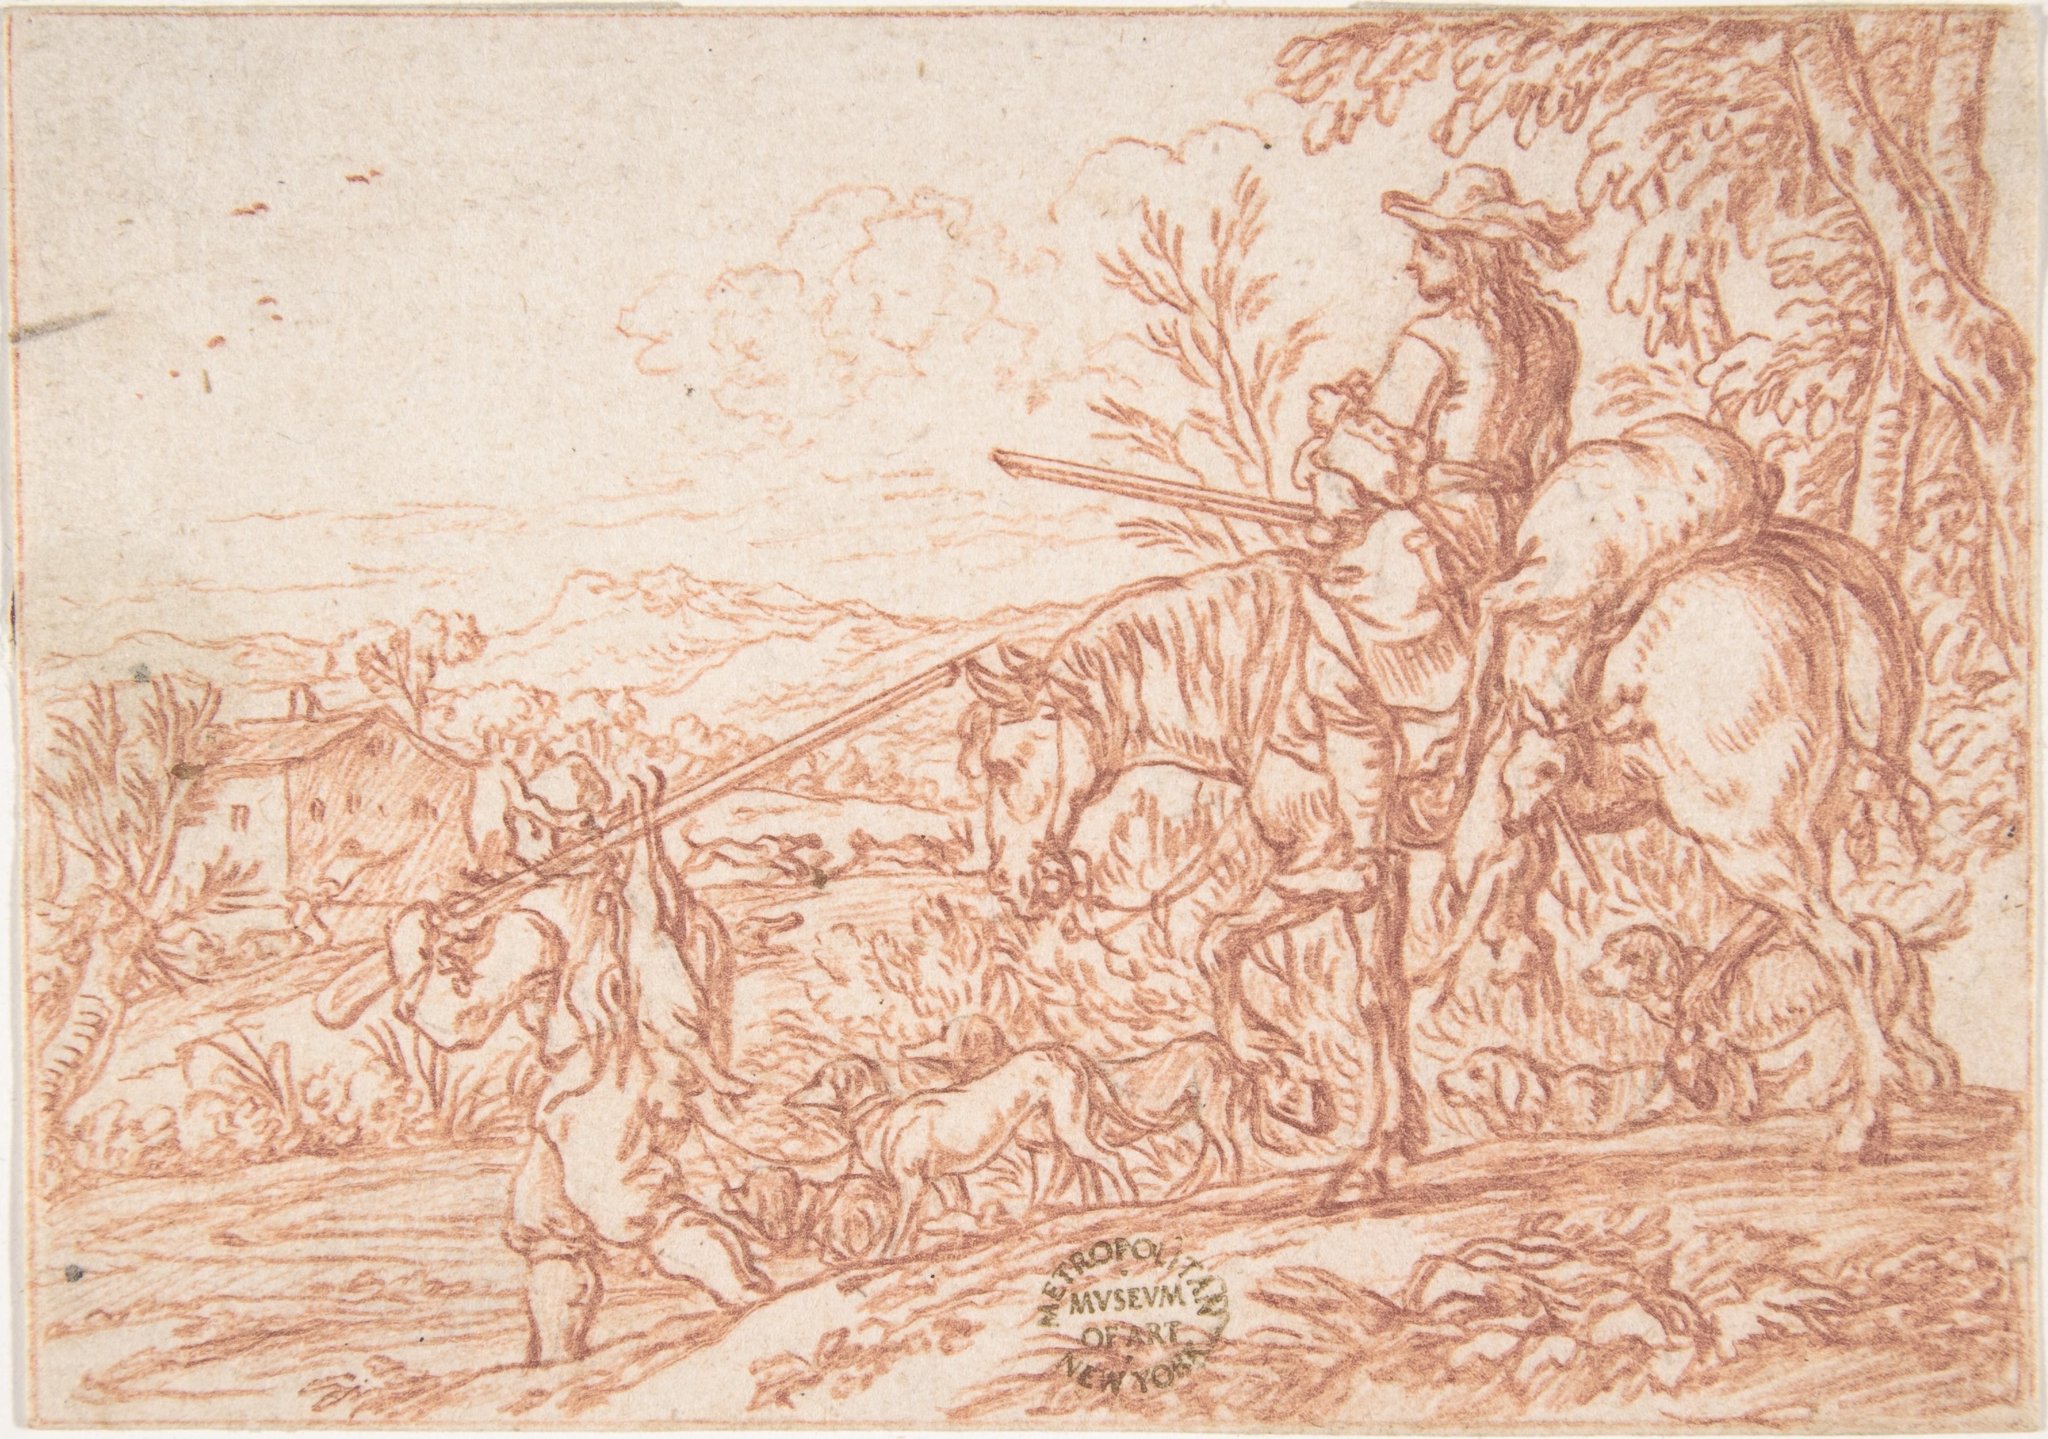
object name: drawing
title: November (one of a series representing the labors of the months)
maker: jonas umbach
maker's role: artist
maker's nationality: german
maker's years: 1624-1693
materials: chalk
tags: houses,men,hunting,deer,dogs,horses,autumn